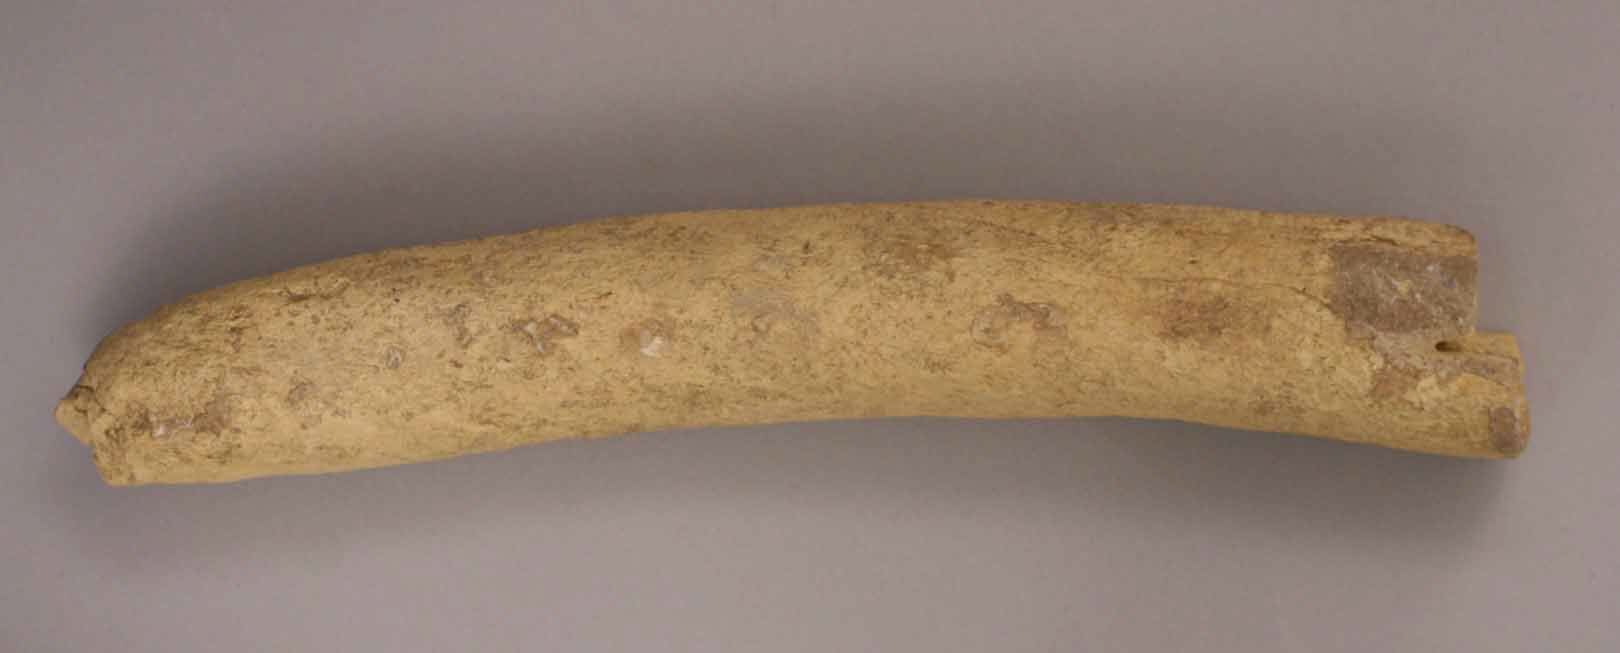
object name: kiln rod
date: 801-900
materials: earthenware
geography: iraq